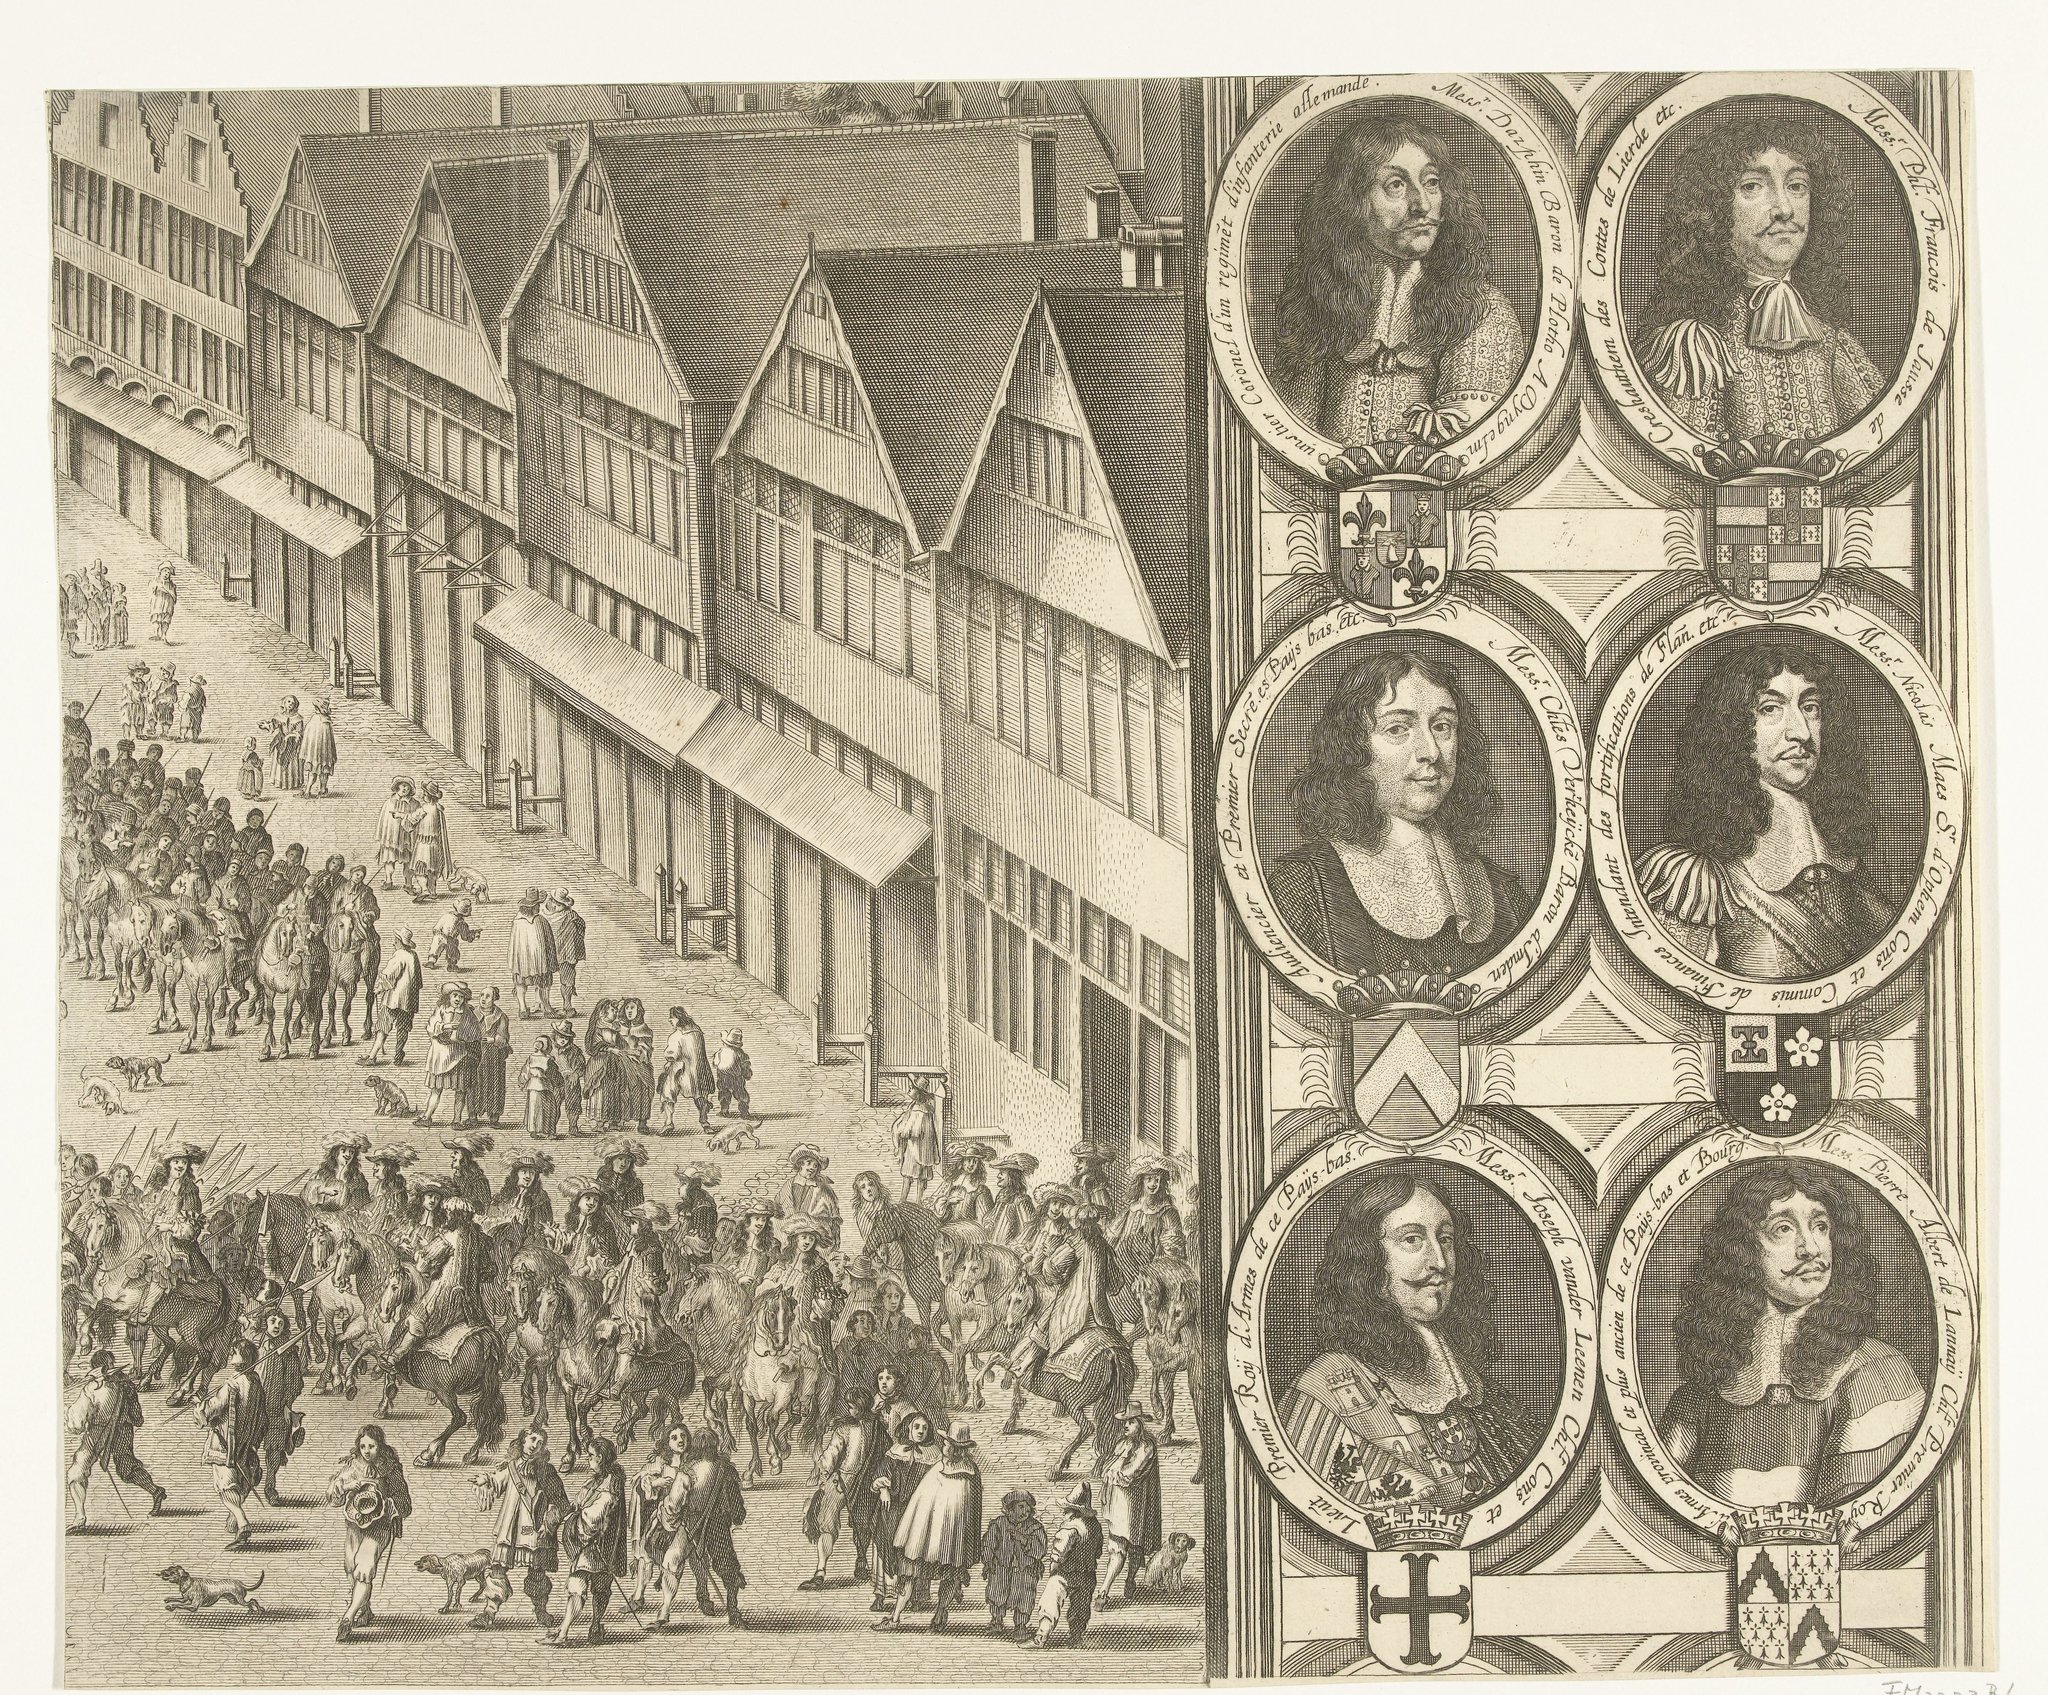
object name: print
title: Proclamatie te Gent van Karel II van Spanje als graaf van Vlaanderen (blad 6), 1666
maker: lucas vorsterman (ii)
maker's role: print maker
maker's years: 1624-1667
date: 1666-1667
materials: paper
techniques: engraving, etching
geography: southern netherlands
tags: karel ii (koning van spanje), ceremonial procession, parade, pageant ~ installation of a ruler, festivities (+ parade, pageant, cavalcade ~ festive activities)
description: Ceremonie op de Vrijdagmarkt te Gent bij de proclamatie van de Spaanse koning Karel II als graaf van Vlaanderen, 2 mei 1666. Blad 6 in een ongemonteerde ensemble van 12 platen van de ceremonie en cavalcade op het plein en 118 portretten van de hoogwaardigheidsbekleders die bij de plechtigheid aanwezig waren.